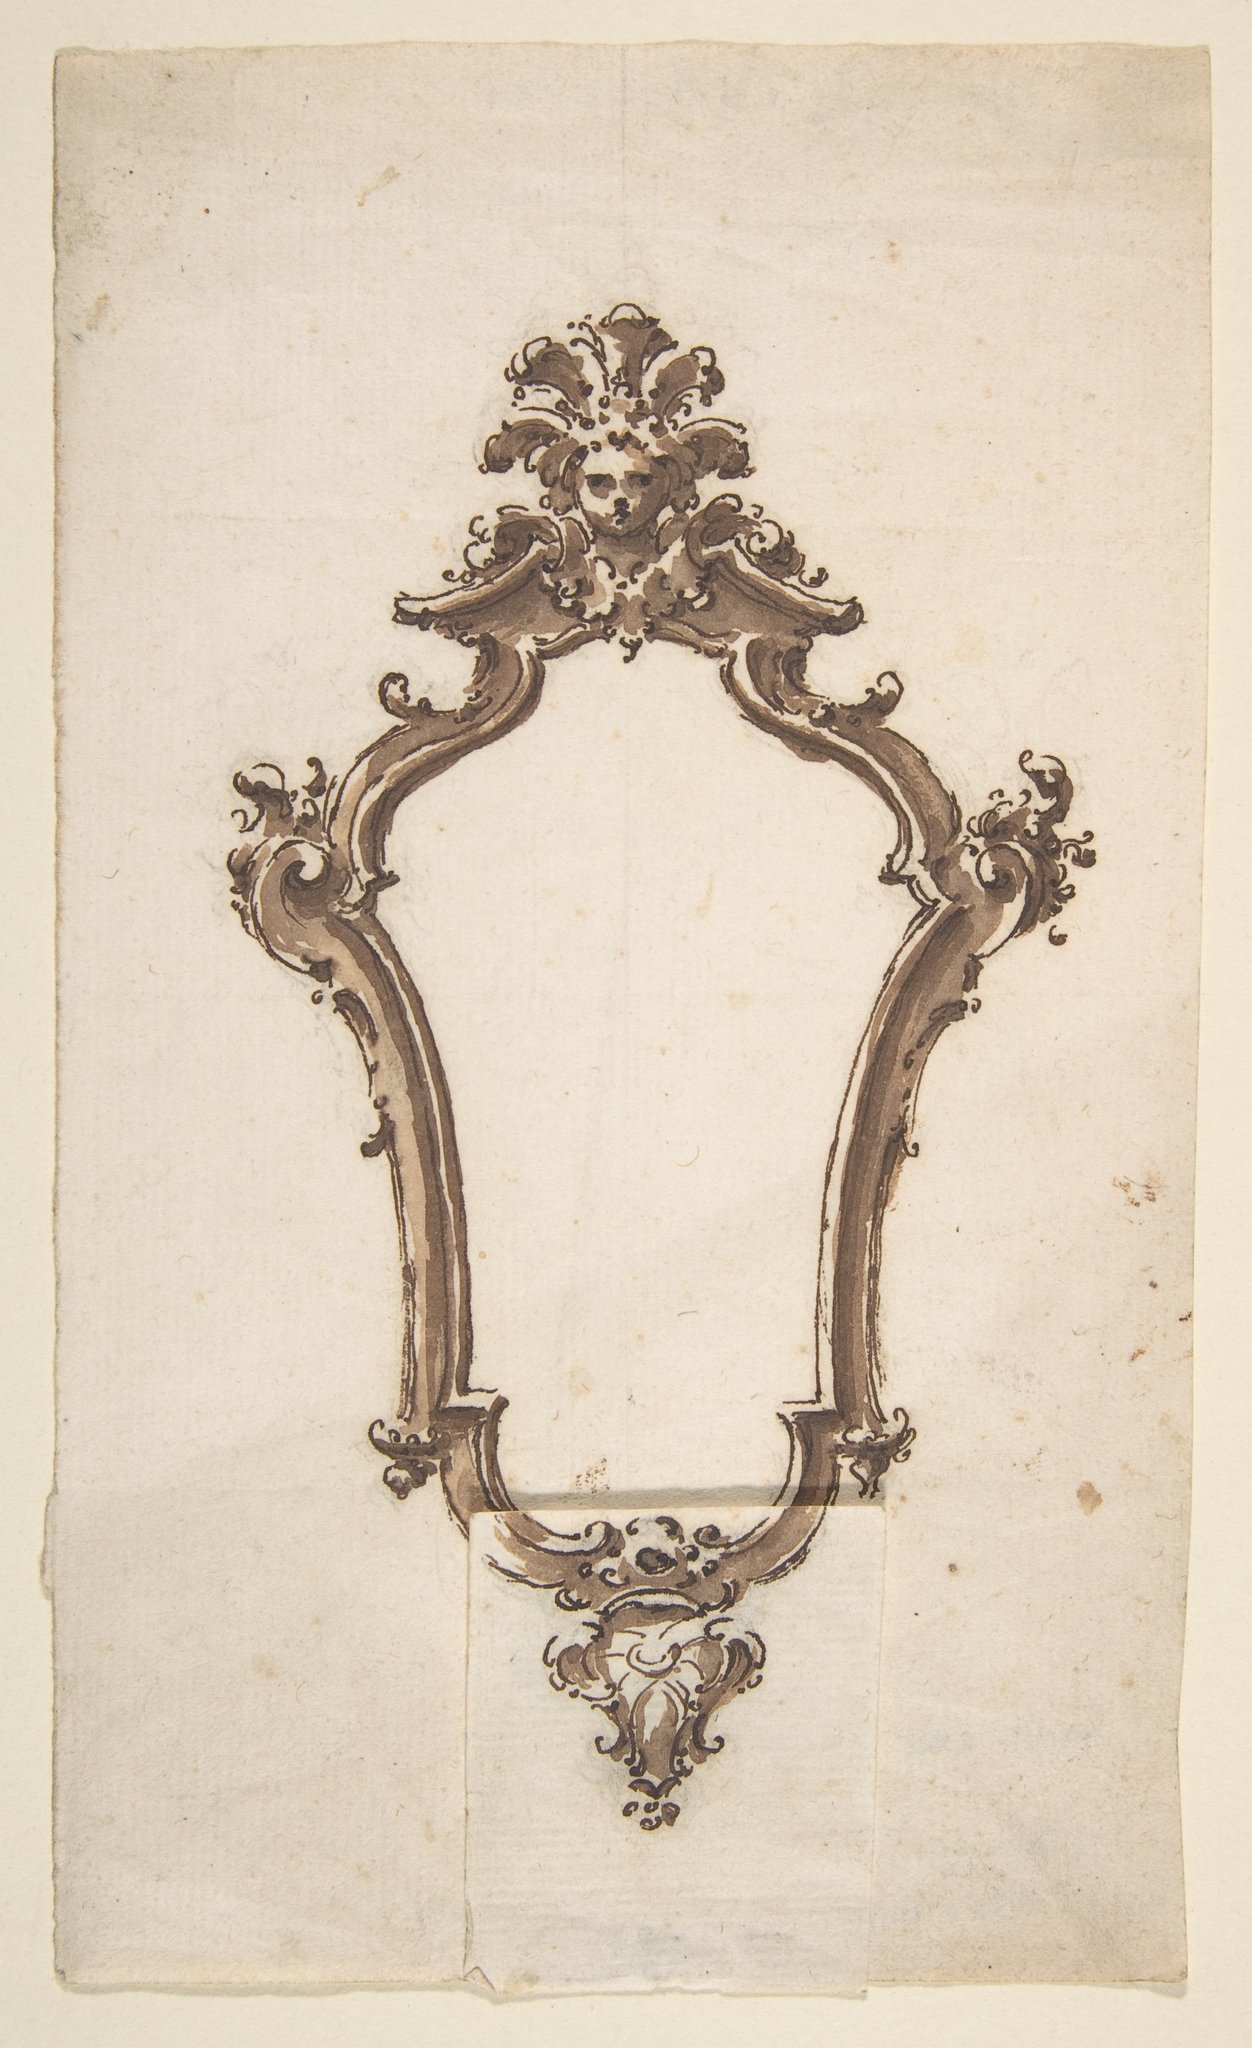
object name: drawing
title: Design for a Frame in the Form of a Cartouche (Mirror?)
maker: giovanni battista natali iii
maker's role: artist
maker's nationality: italian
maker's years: 1698-1765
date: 1698-1765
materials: ink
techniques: brush, pen, wash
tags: cartouches